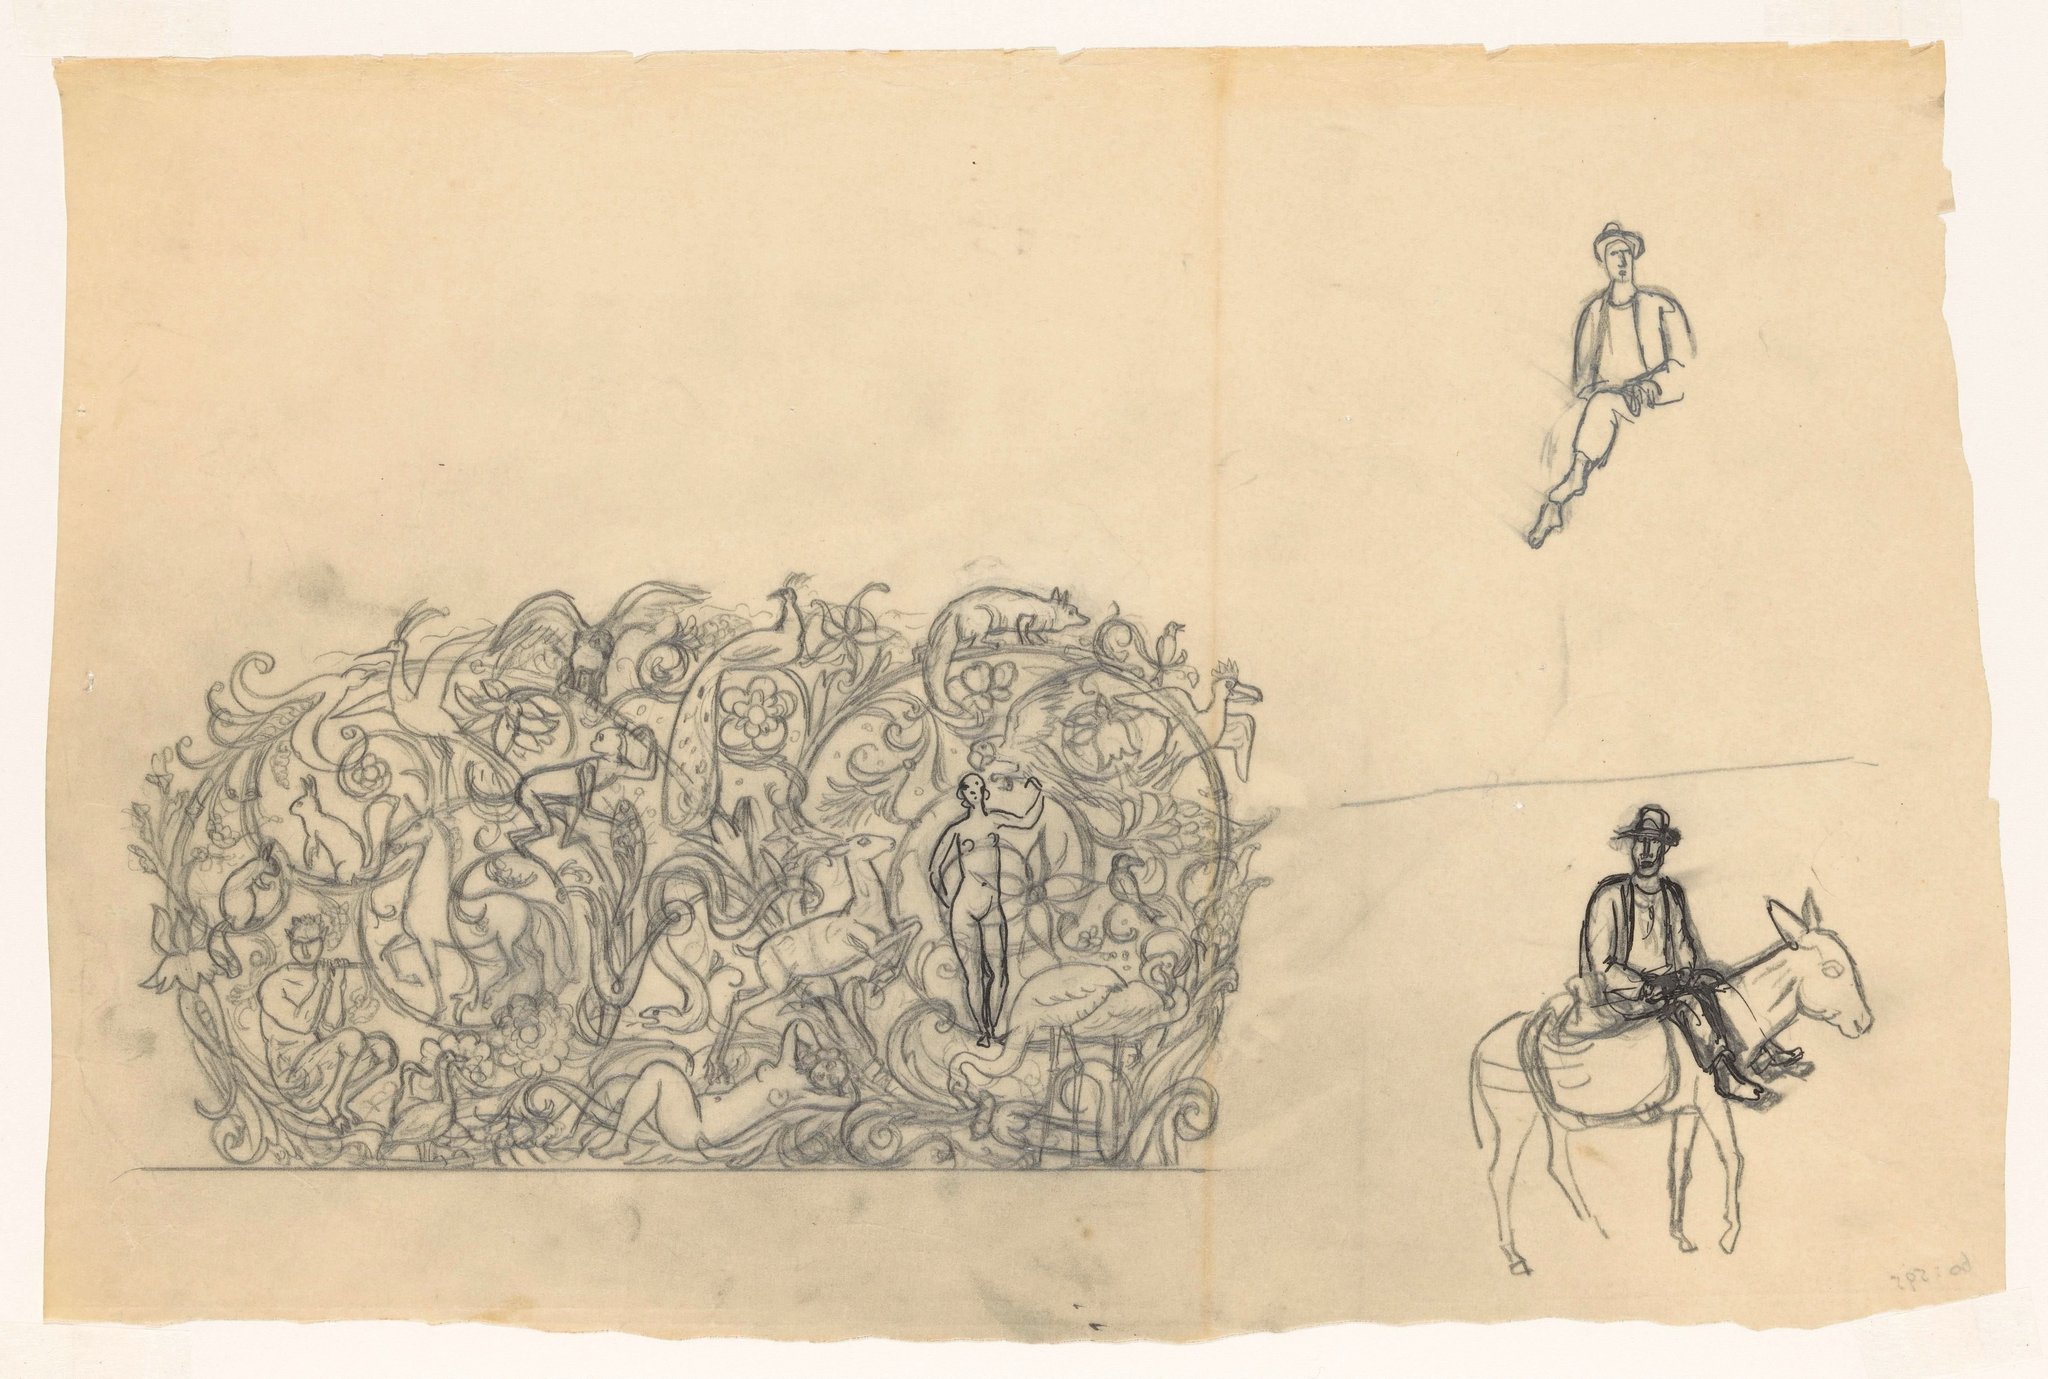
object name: drawing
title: Studieblad met man op een ezel en een ornament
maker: leo gestel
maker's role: draughtsman, print maker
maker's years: 1881-1941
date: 1891-1941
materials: ink, pencil, paper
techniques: pen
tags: riding a horse, ass, or mule; rider, horseman, acanthus ~ ornament, animal interlace ~ ornament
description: Ornament met acanthusbladeren verweven met dieren, naakte vrouwen en satyrs.